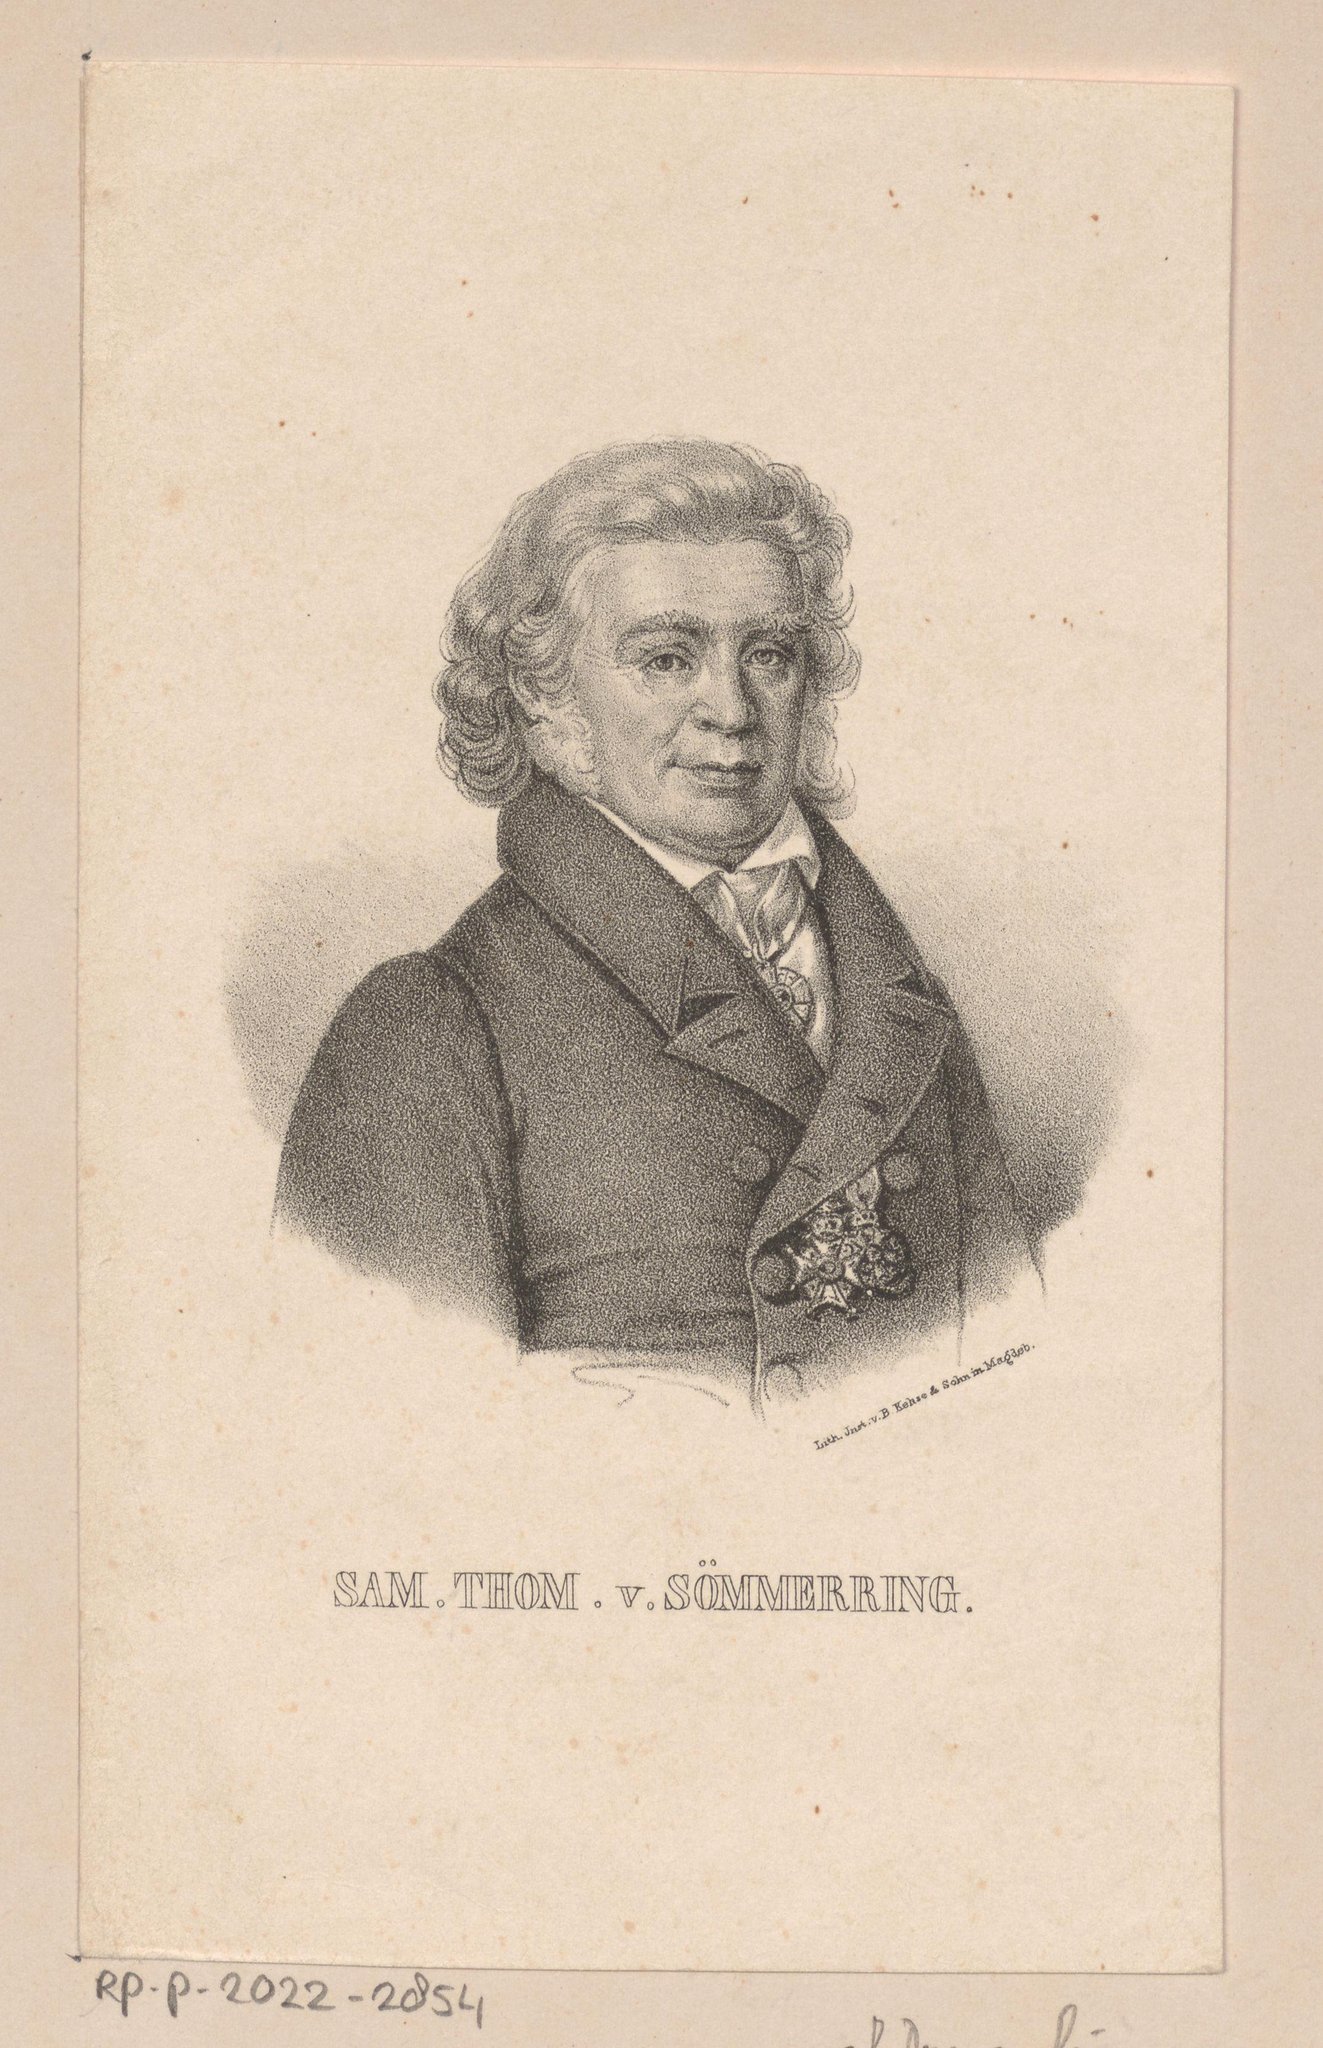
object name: print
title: Portret van Samuel Thomas von Sömmerring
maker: Anonymous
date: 1830-1840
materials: paper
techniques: lithograph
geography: magdeburg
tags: physicist, historical persons, physiology and anatomy (+ portrait of scholar, scientist), physician, doctor